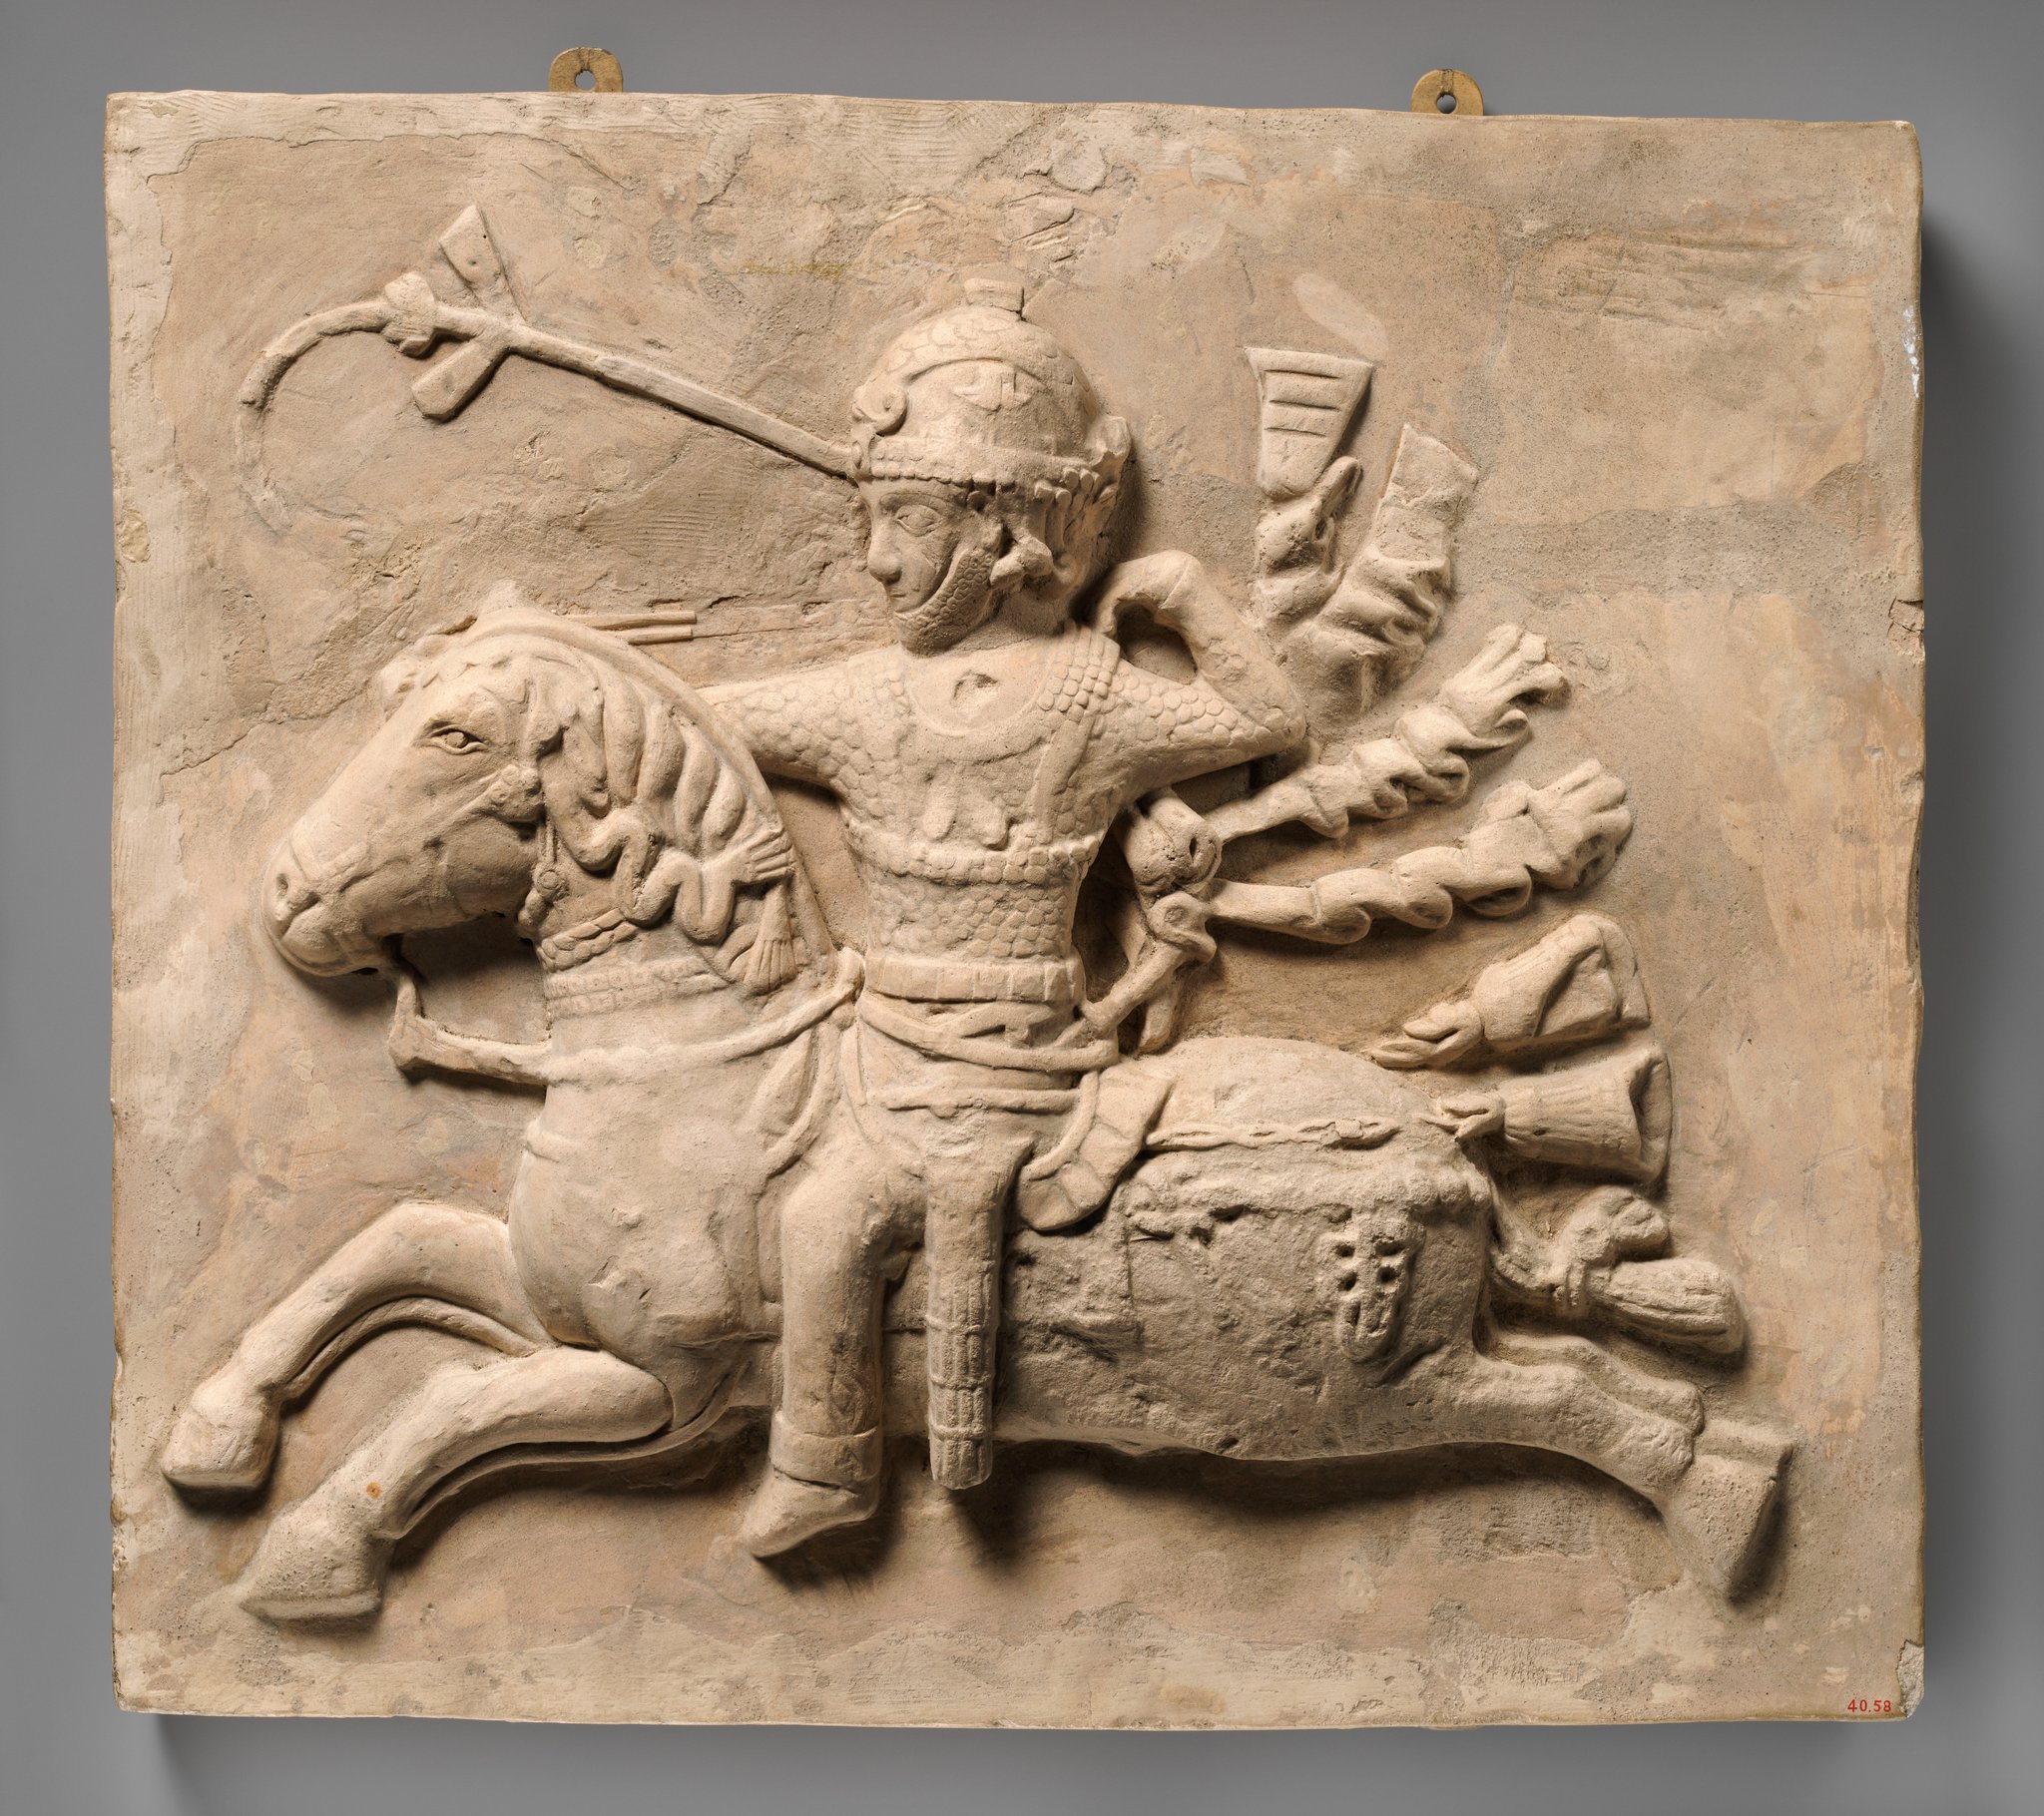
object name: relief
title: Panel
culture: sasanian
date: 501-700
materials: plaster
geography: iran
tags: bow and arrow,men,horses